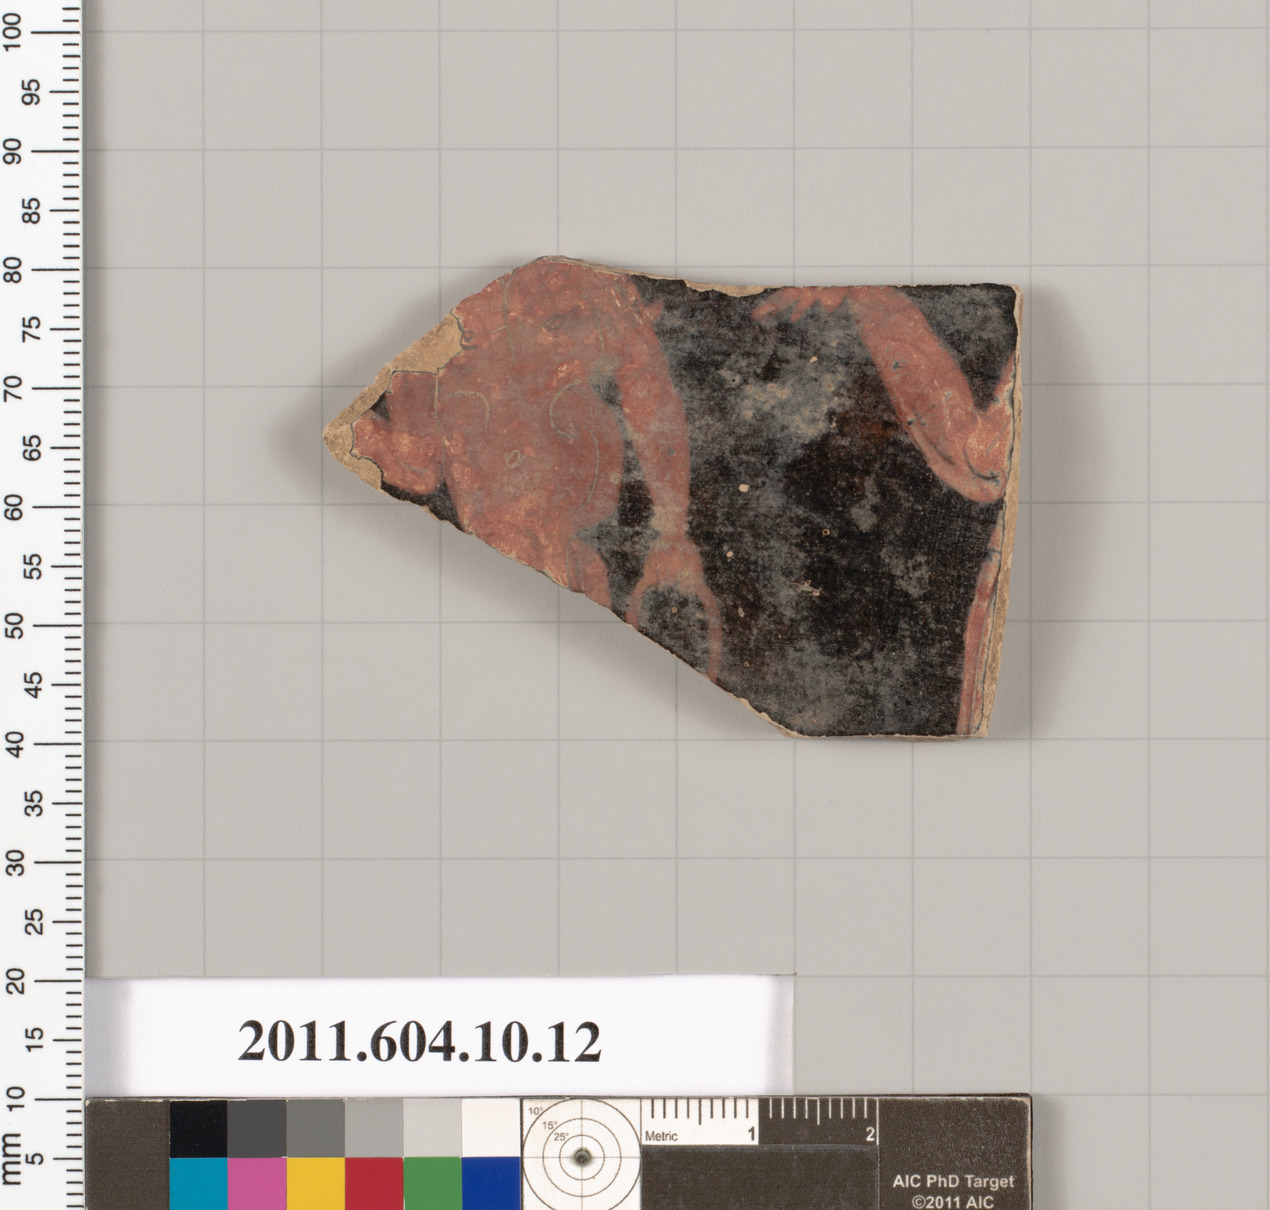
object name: kylix fragment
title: Terracotta fragment of a kylix (drinking cup)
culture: etruscan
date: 434-368 BCE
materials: terracotta